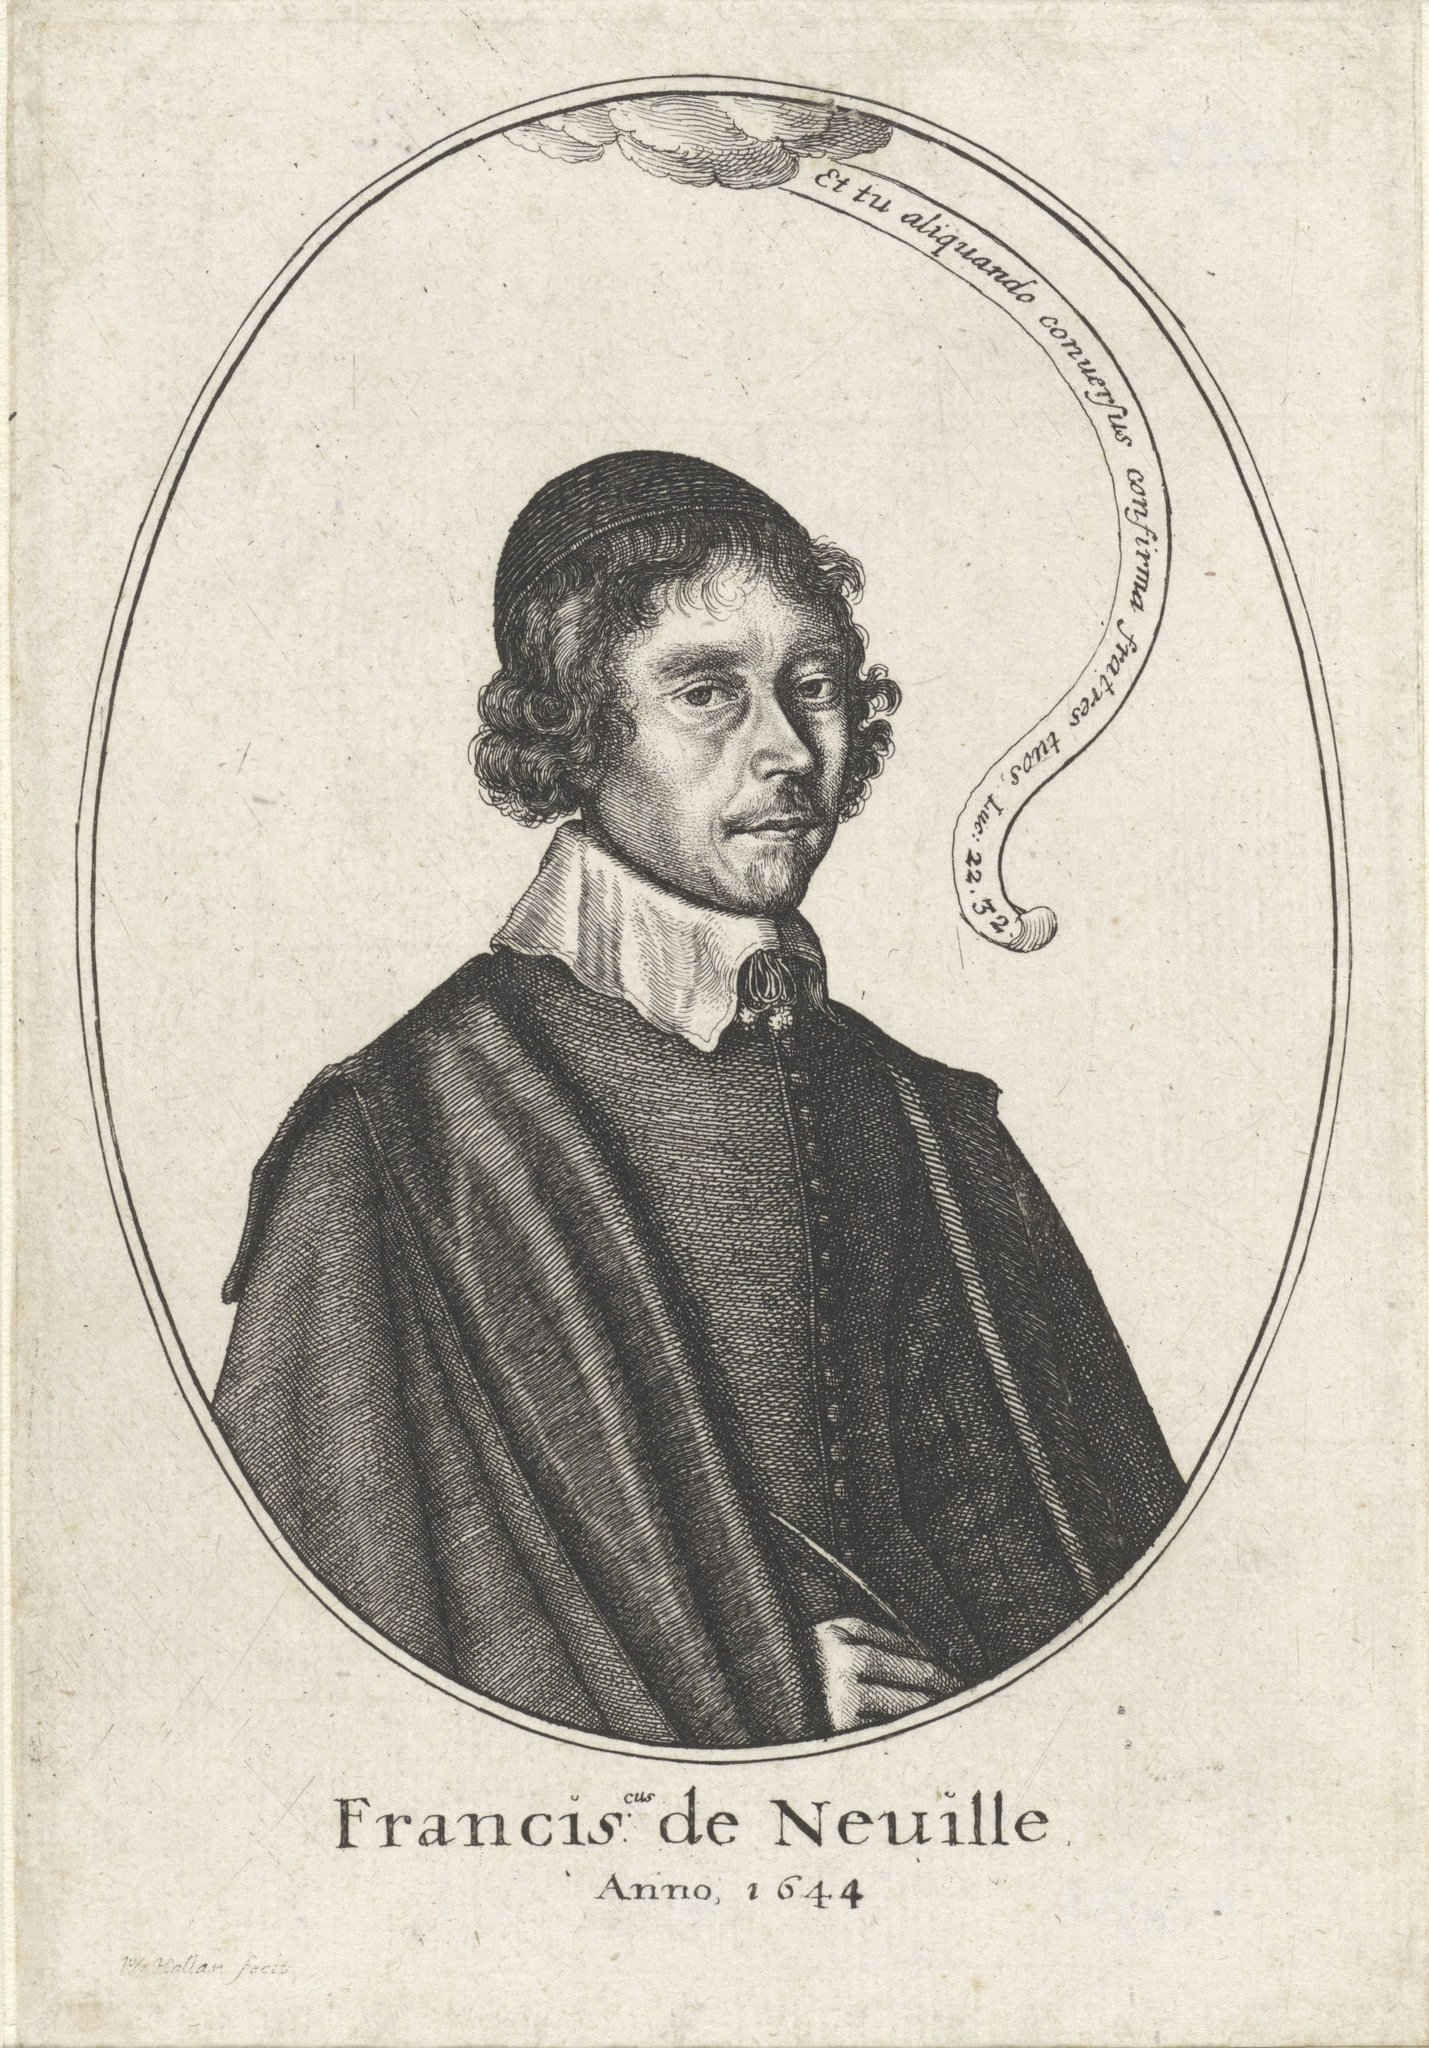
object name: print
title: Portret van Franciscus de Neville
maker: wenceslaus hollar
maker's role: draughtsman, print maker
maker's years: 1607-1677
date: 1644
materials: paper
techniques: etching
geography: london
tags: clergyman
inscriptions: collector's mark: Lugt 151, collector's mark: Lugt 2760, collector's mark: Lugt 2166, inscription: ‘J.B.’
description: Portret van de puriteinse geestelijke Franciscus de Neville.